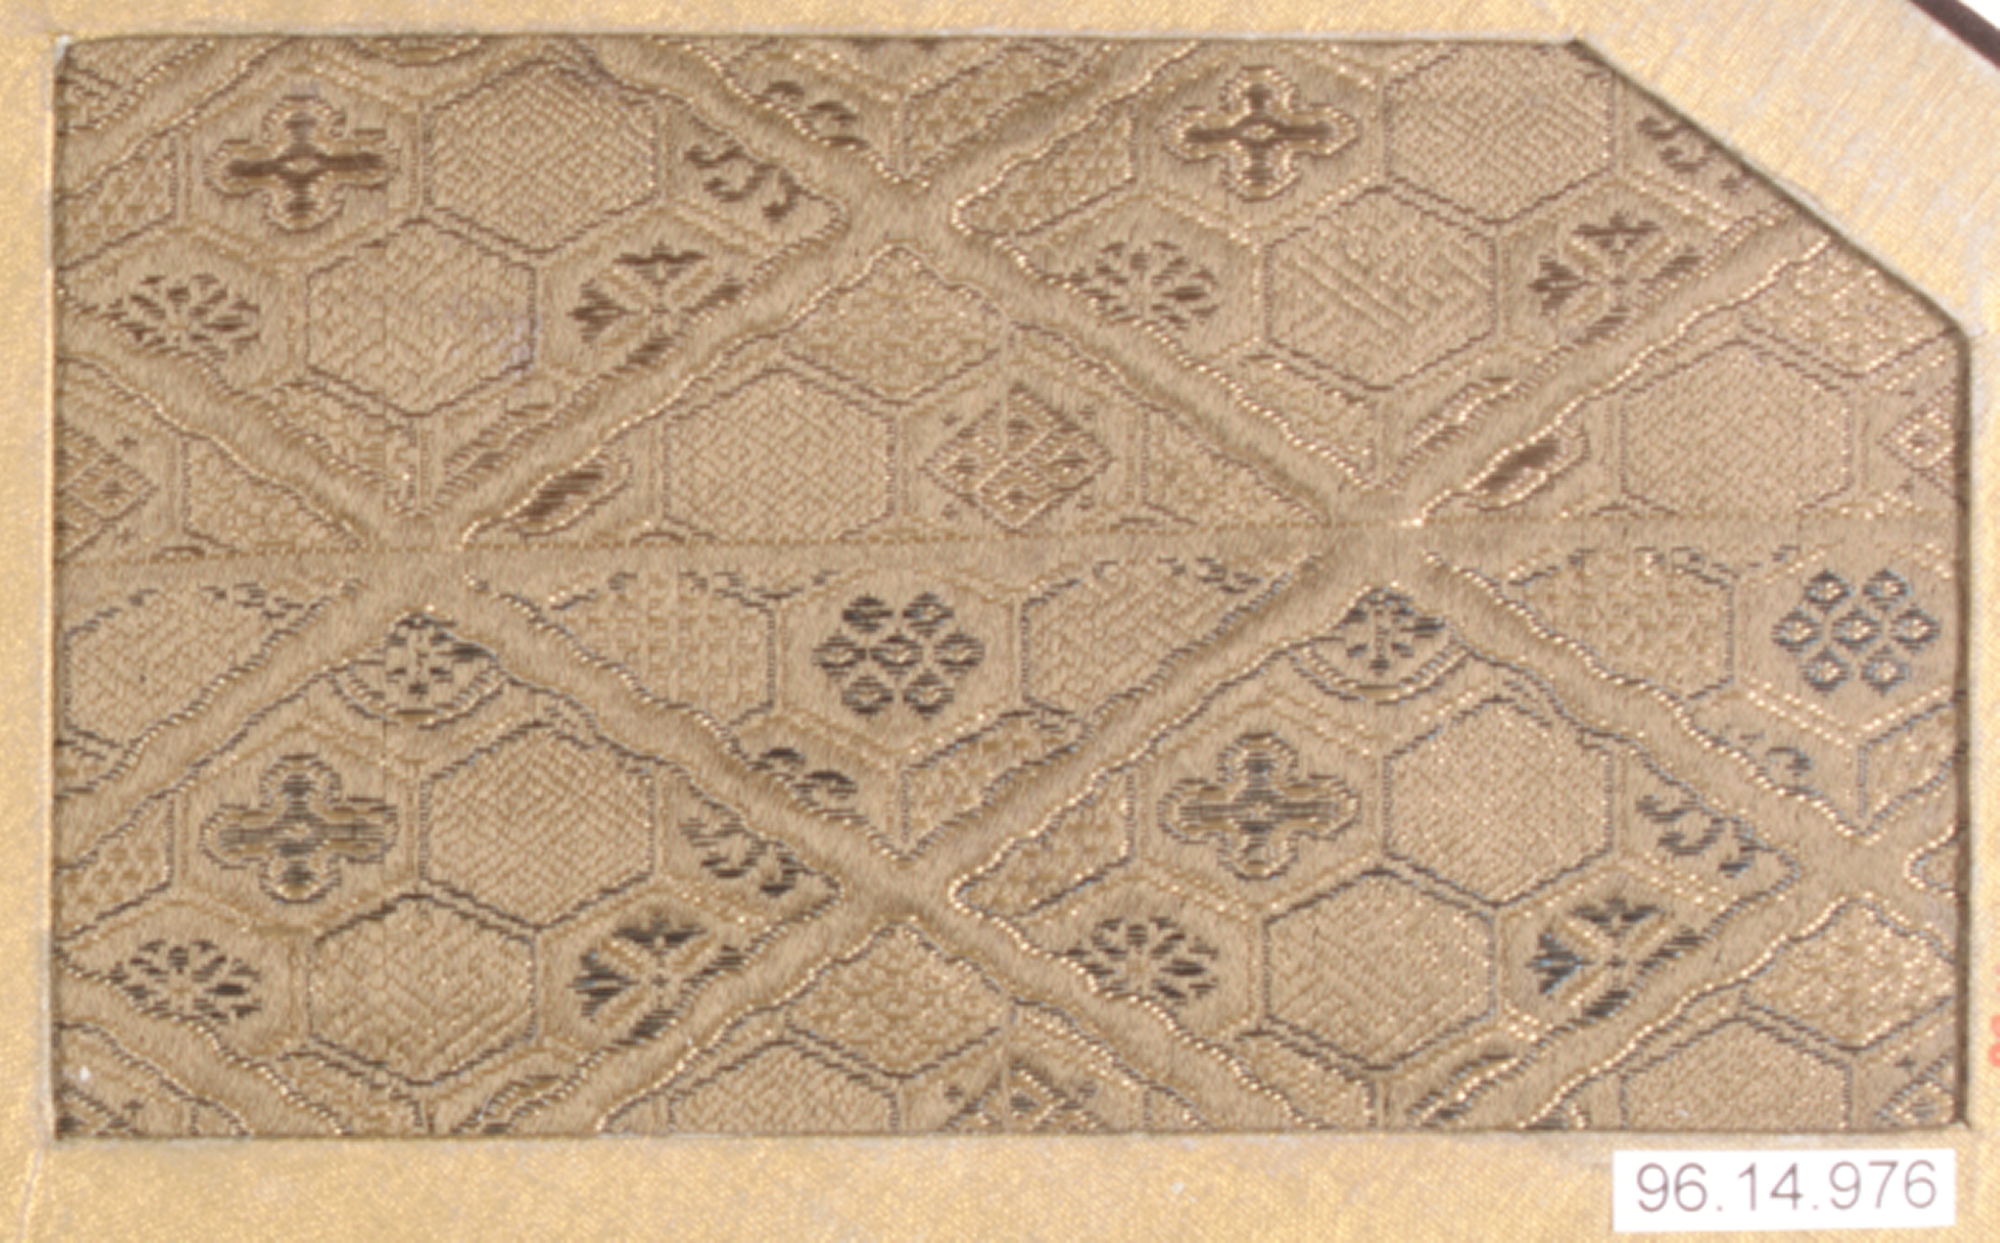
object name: piece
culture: japanese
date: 1701-1900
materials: silk